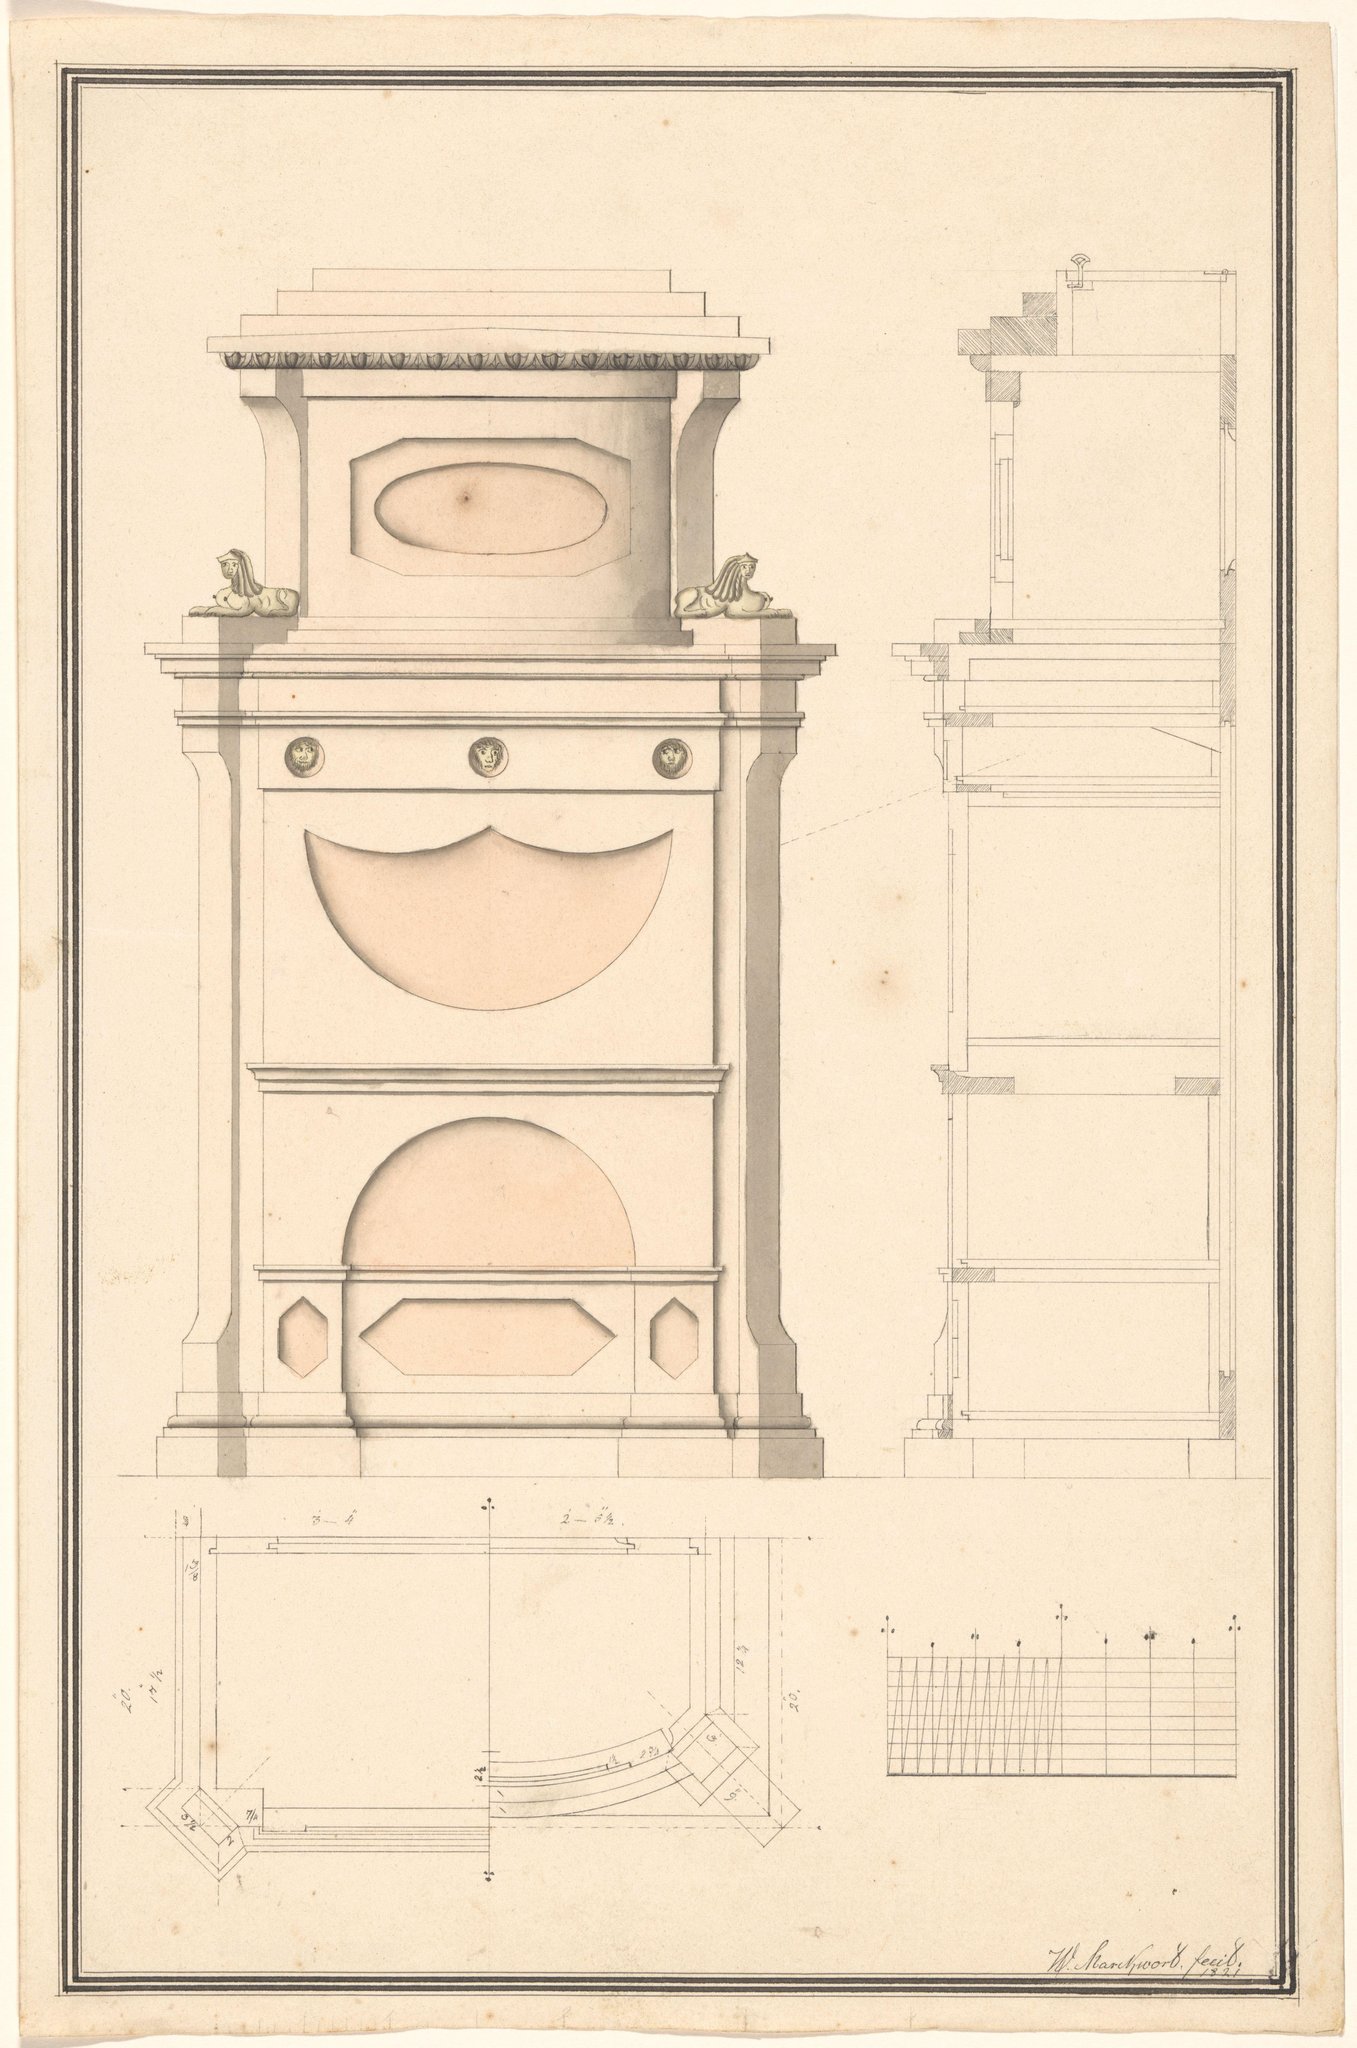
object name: drawing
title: Secretaire met twee sfinxen, voor- en zijaanzicht met een in tweeën gedeelde doorsnede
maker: carl wilhelm marckwort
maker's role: draughtsman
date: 1821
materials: ink, paper, watercolor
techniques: brush, pen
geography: berlin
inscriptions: signature and date: ‘W. Marckwort. fecit. / 1821.’, watermark: ‘J WHATMAN / TURKEY MILLS / 1819’